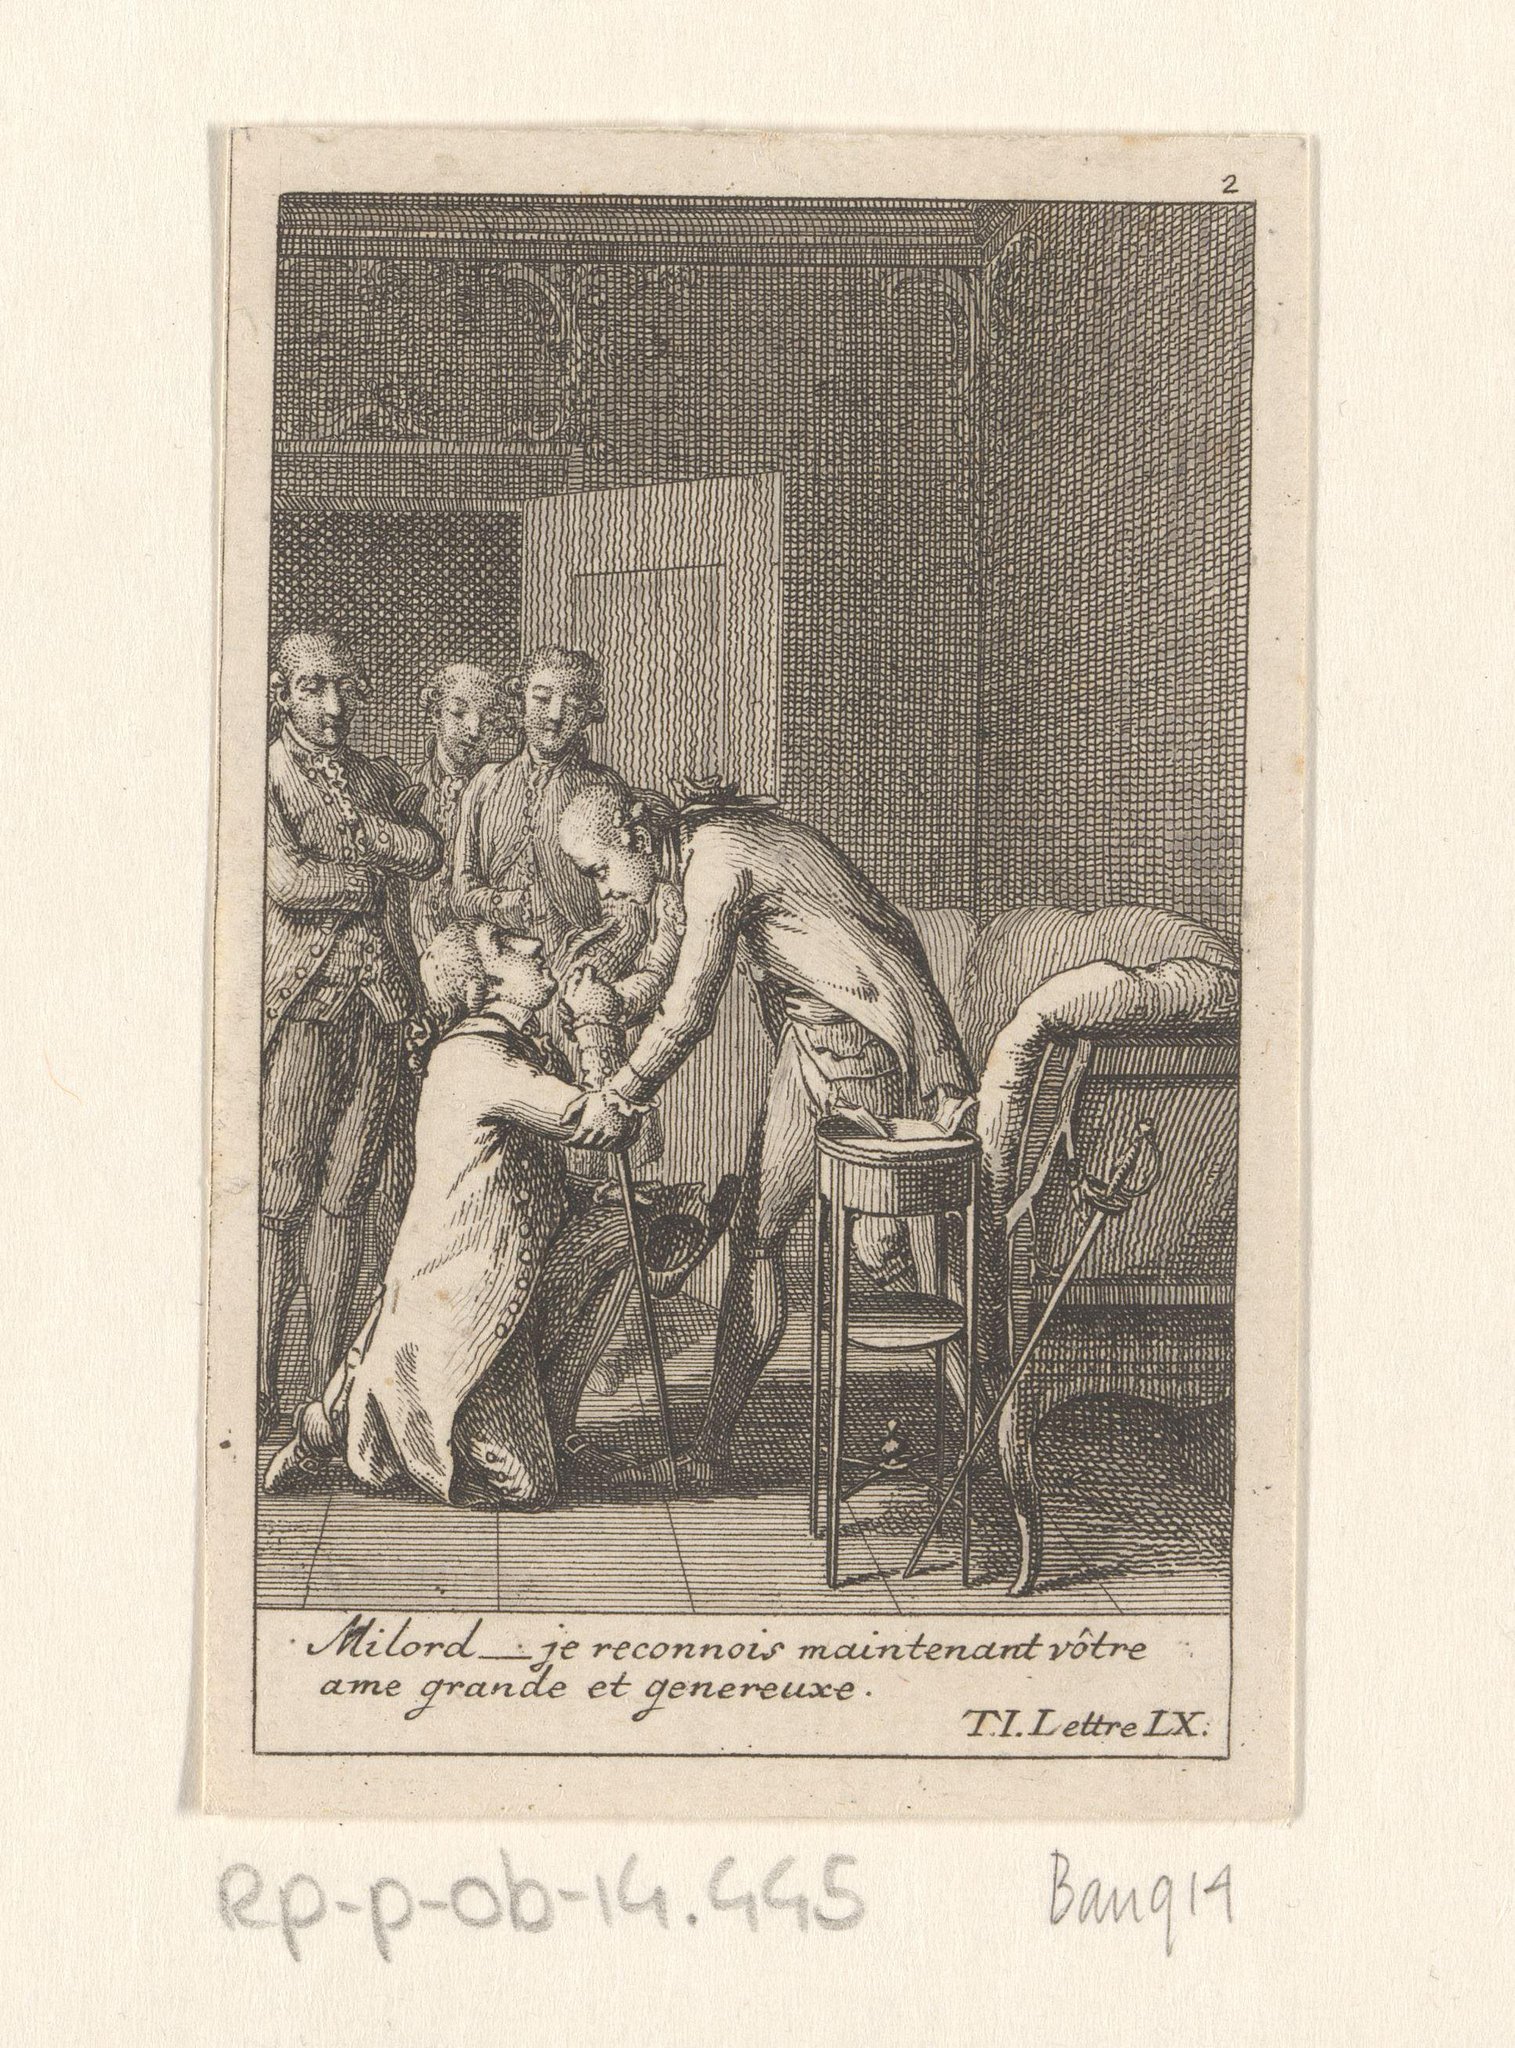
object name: print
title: Lord Bomston op zijn knieën voor St. Preux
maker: daniel nikolaus chodowiecki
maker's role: draughtsman, print maker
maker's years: 1726-1801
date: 1782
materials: paper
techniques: etching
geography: berlin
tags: walking-stick, staff, kneeling figure, conversation, dialogue; conversation piece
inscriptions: collector's mark: Lugt 2228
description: Vervaardigd voor Jean-Jacques Rousseaus 'Neue Héliose'. Latere staat gebruikt voor: Almanac généalogique pour l'année 1783. Berlijn: s.n., 1782.